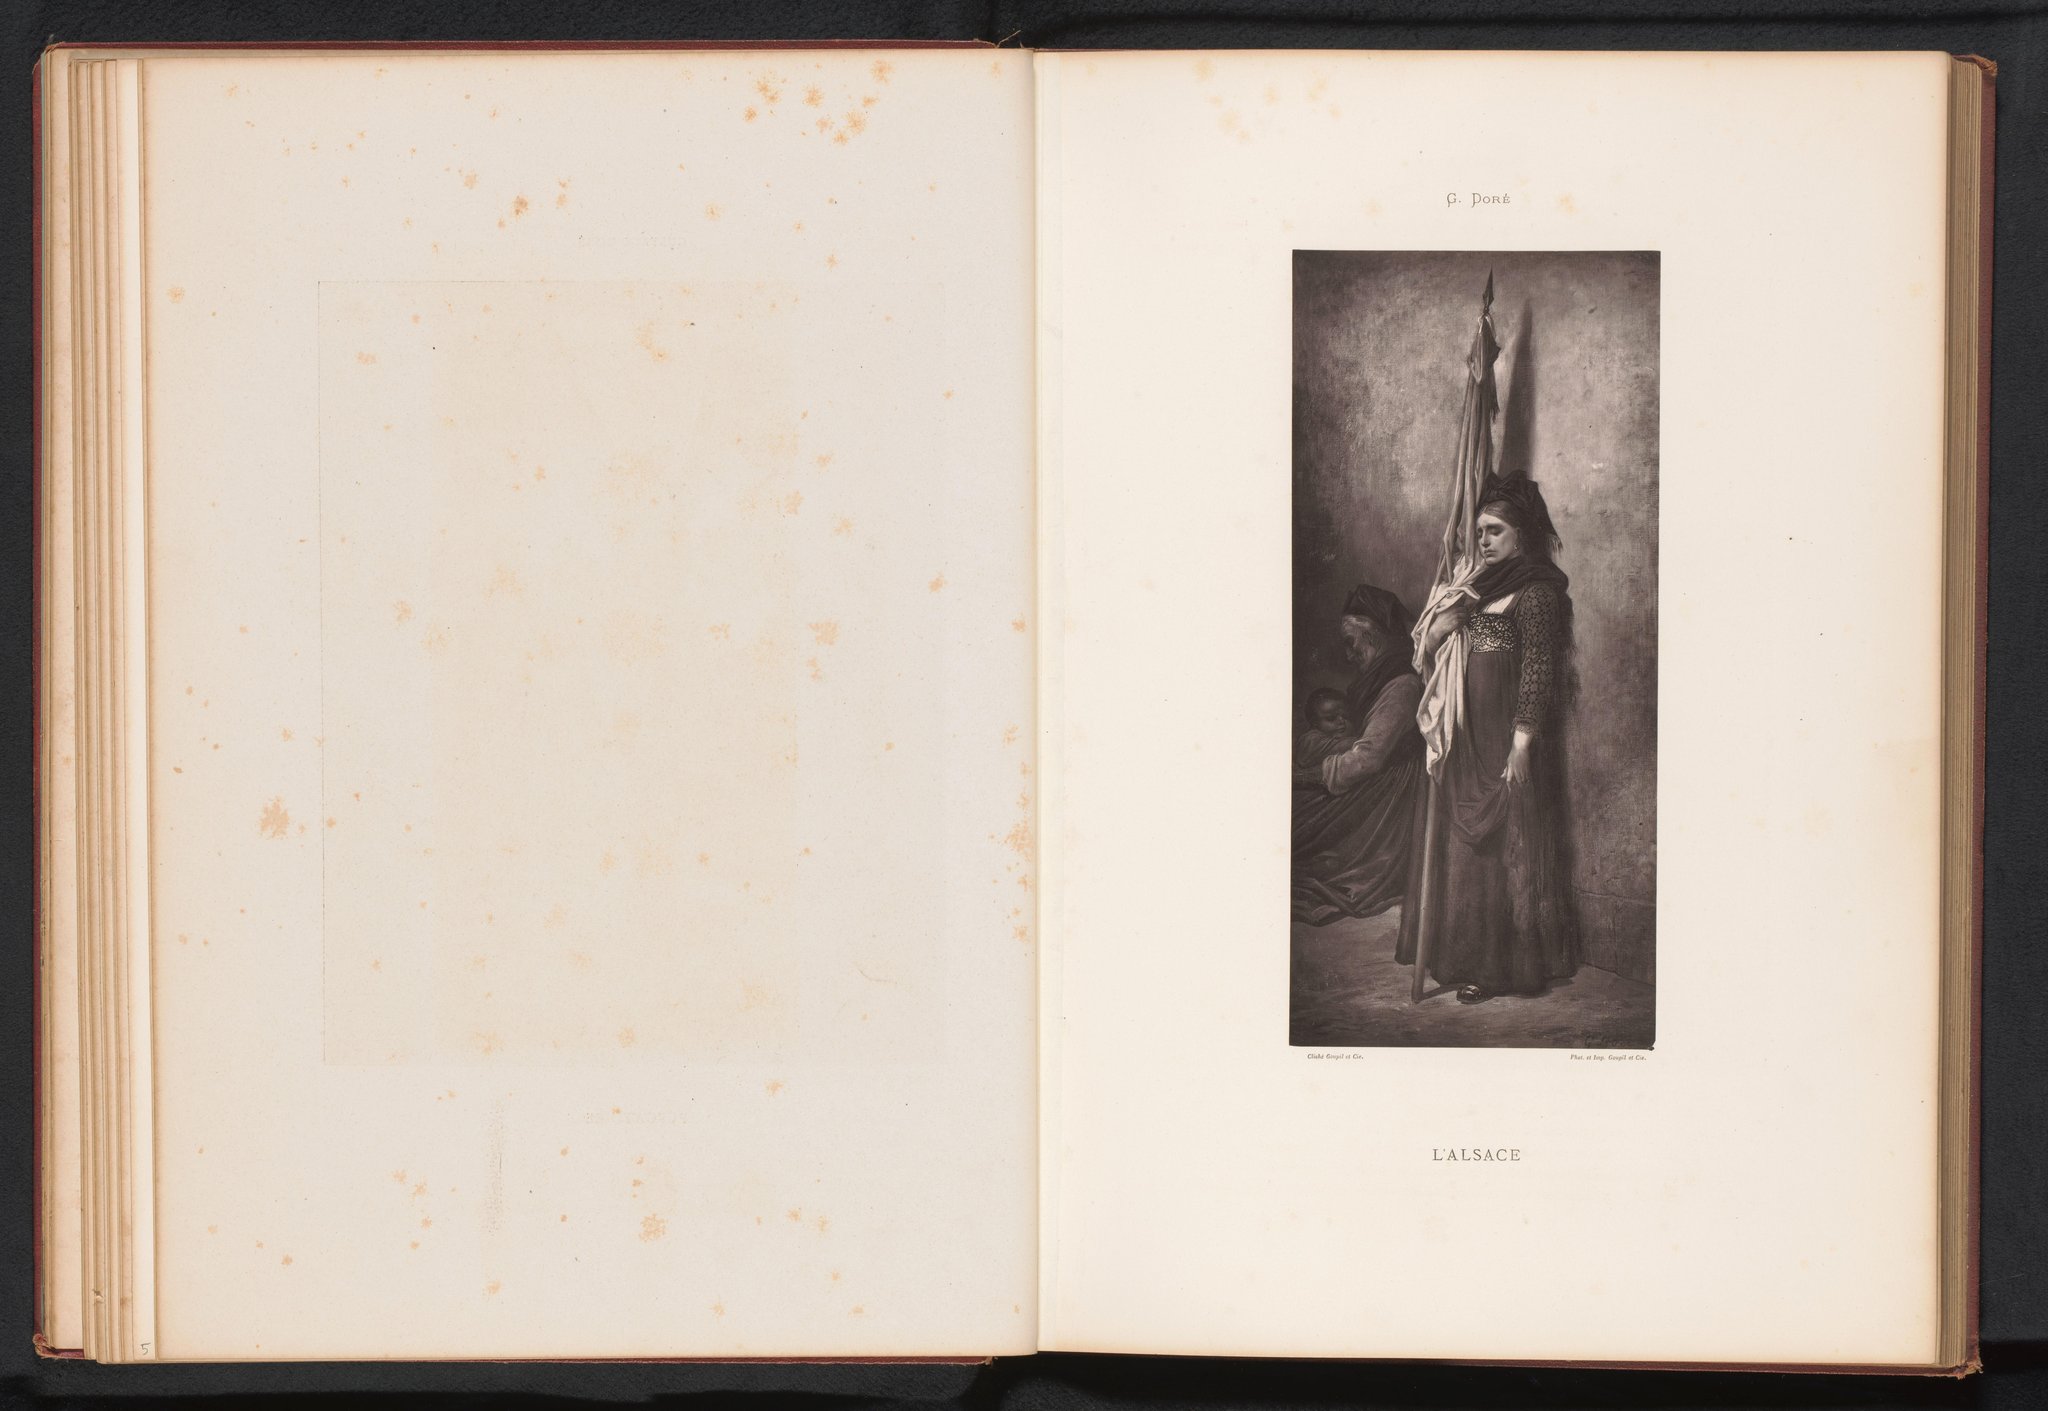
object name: page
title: Reproductie van L'Alsace door Gustave Doré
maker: gustave doré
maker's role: draughtsman, print maker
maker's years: 1832-1883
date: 1874-1879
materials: paper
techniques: woodburytype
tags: helved weapons, polearms (for striking, hacking, thrusting): pike, adult woman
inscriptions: name: ‘G. Doré’